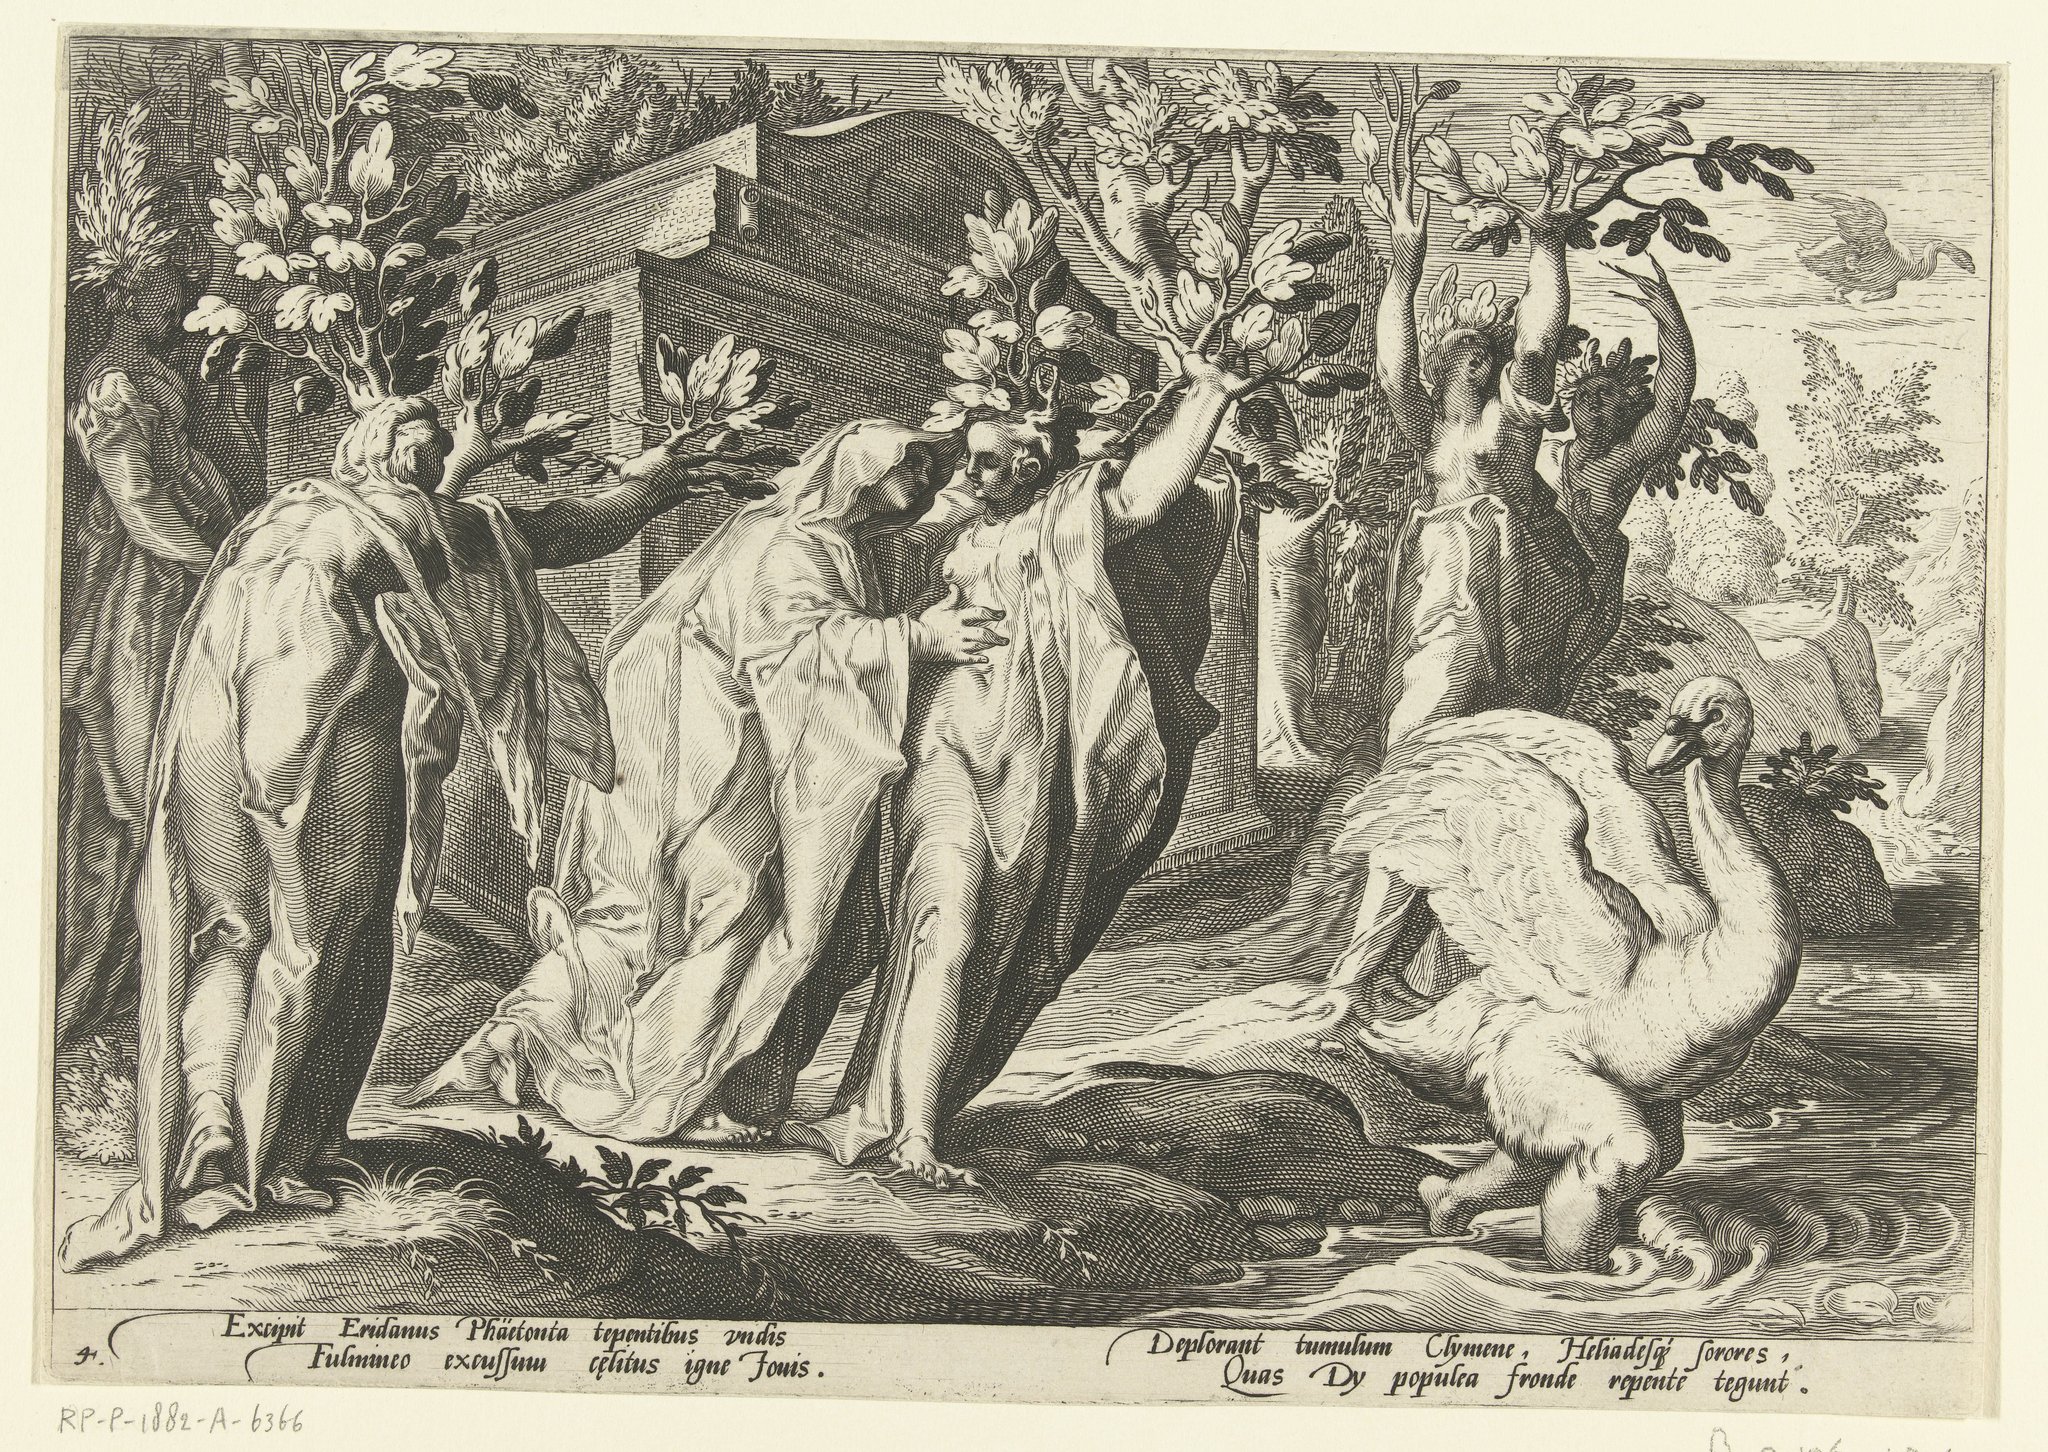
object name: print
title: Phaëthons zussen veranderen in populieren en zijn vriend in een zwaan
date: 1590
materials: paper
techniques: engraving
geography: haarlem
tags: cycnus, son of sthenelus, changed into a swan: while grieving over the death of phaethon, cycnus, son of sthenelus, is changed into a swan (ovid, metamorphoses ii 373), heliades changed into poplar-trees: while weeping over phaeton's grave the heliades are changed into poplar-trees, and their tears turn into beads of amber; their mother clymene may be present (ovid, metamorphoses ii 346)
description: De dochters van de zonnegod (de Heliaden) rouwen om hun broer Phaëton en veranderen in populieren. Zijn vriend en verwant Cycnus verandert al rouwend in een zwaan. Onder de voorstelling twee keer twee regels Latijnse tekst. Deze prent is onderdeel van een serie van 52 prenten die verhalen uit Ovidius' Metamorfosen verbeelden. Deze serie valt uiteen in drie genummerde reeksen: twee van 20 prenten en één van 12 prenten. Deze prent behoort tot de tweede reeks.